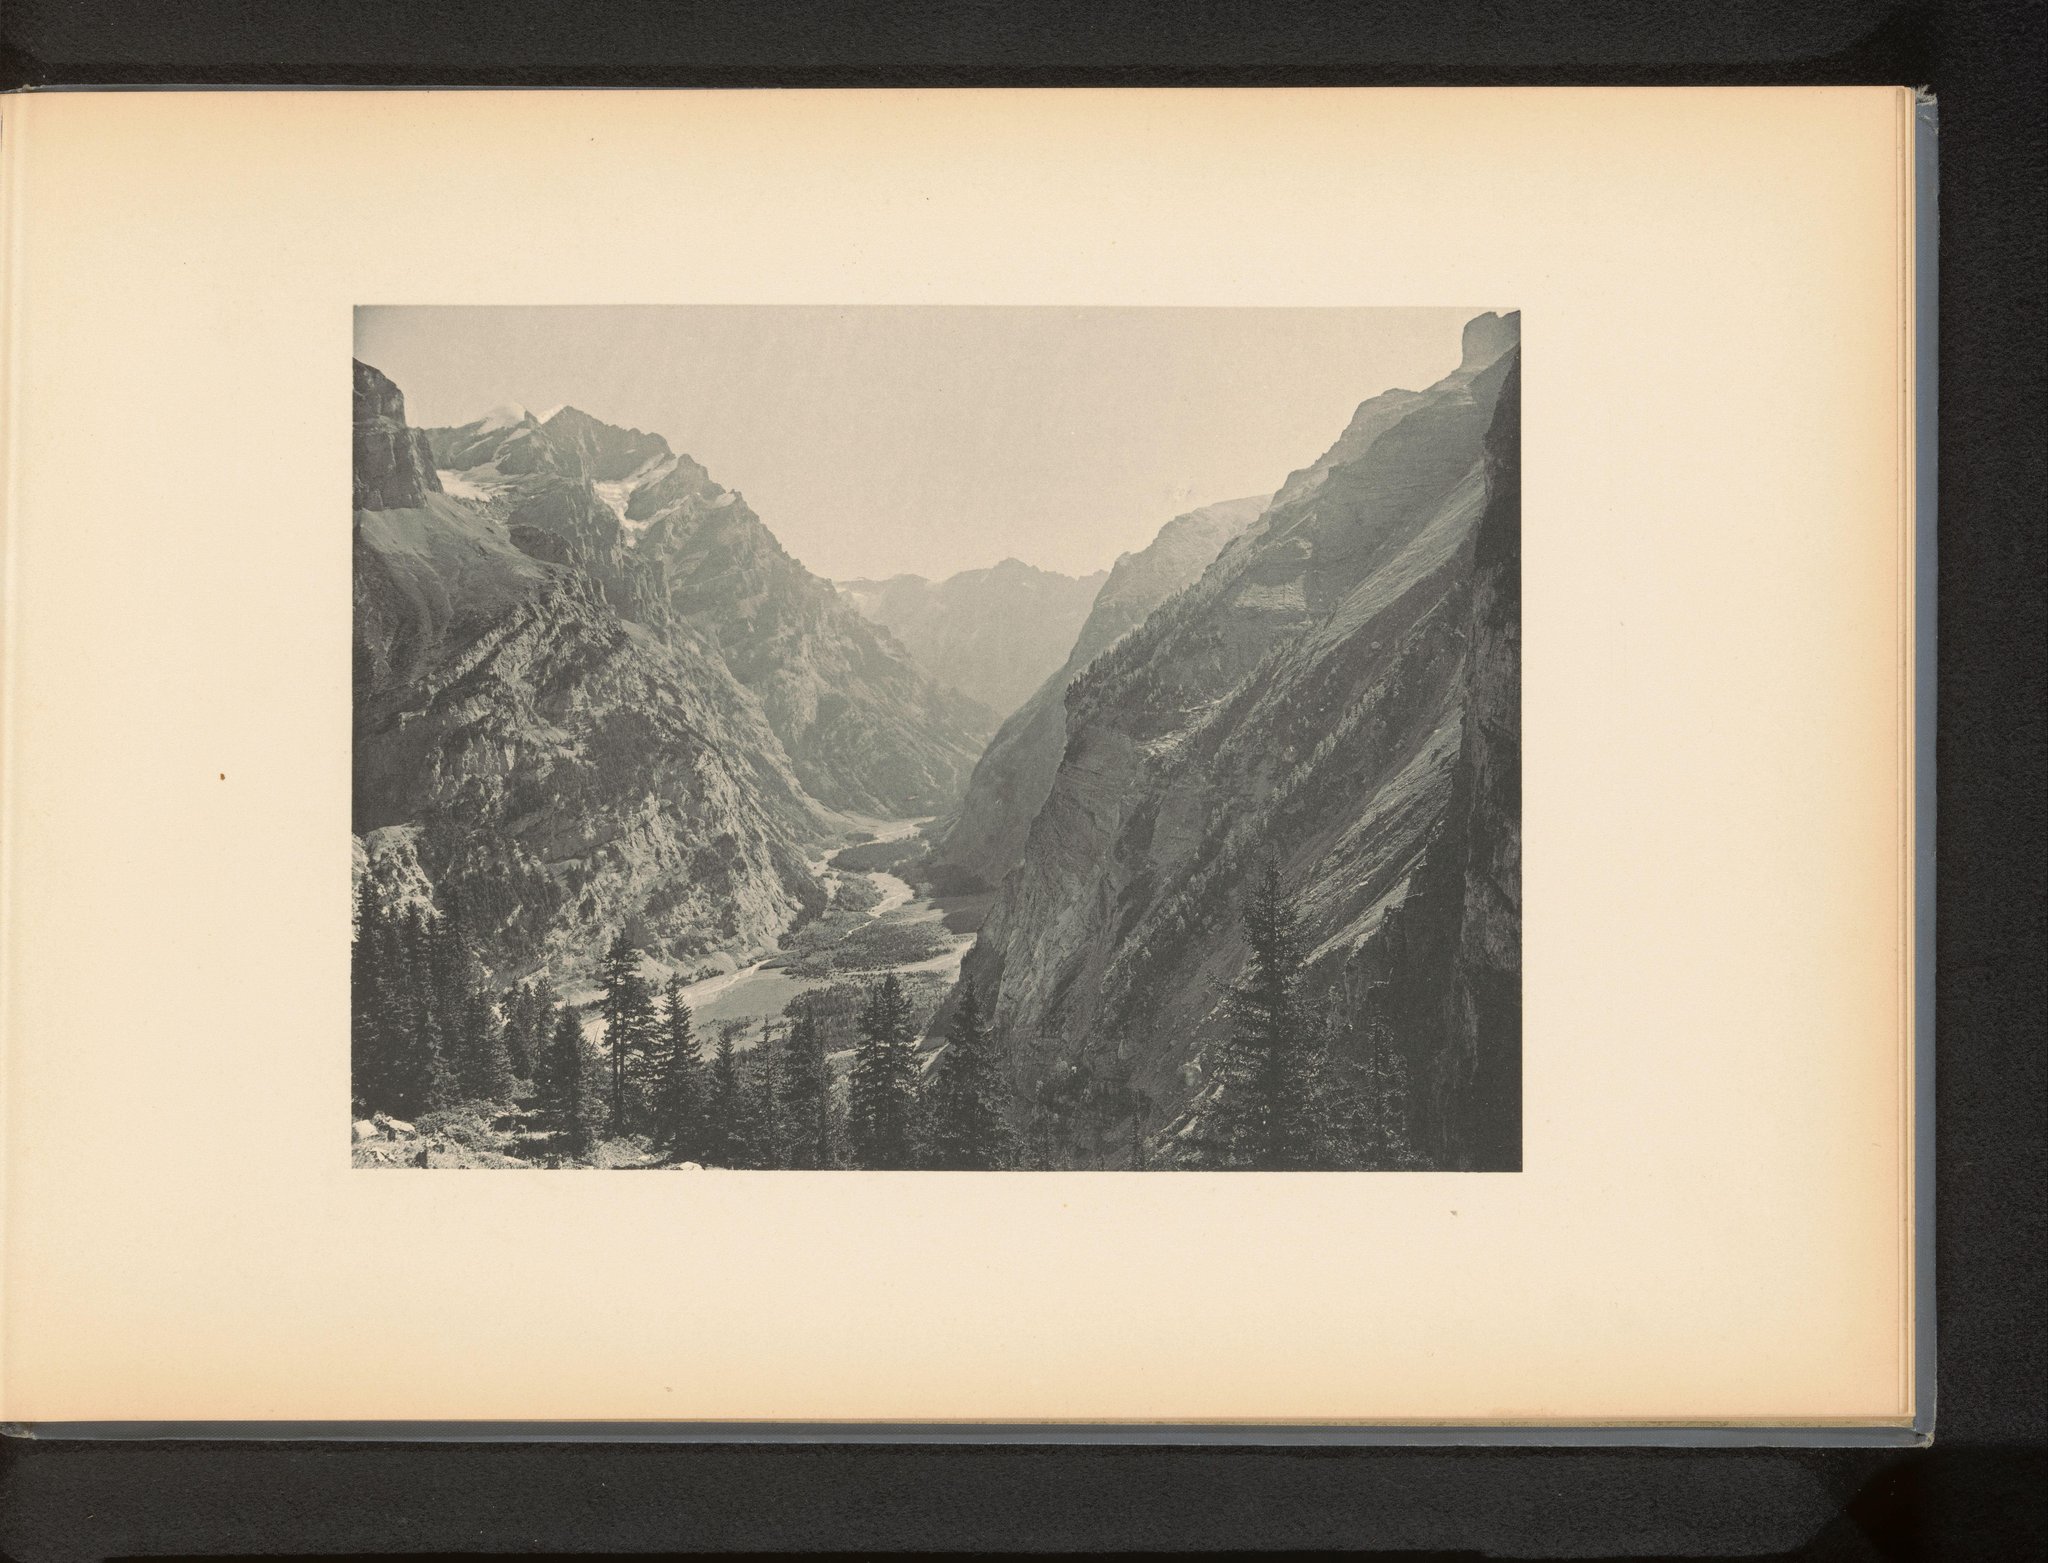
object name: photomechanical print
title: Gezicht op de vallei van Gastern in Kandersteg, Zwitserland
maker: Anonymous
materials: paper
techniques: photograph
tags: dale, valley, landscapes, mountains